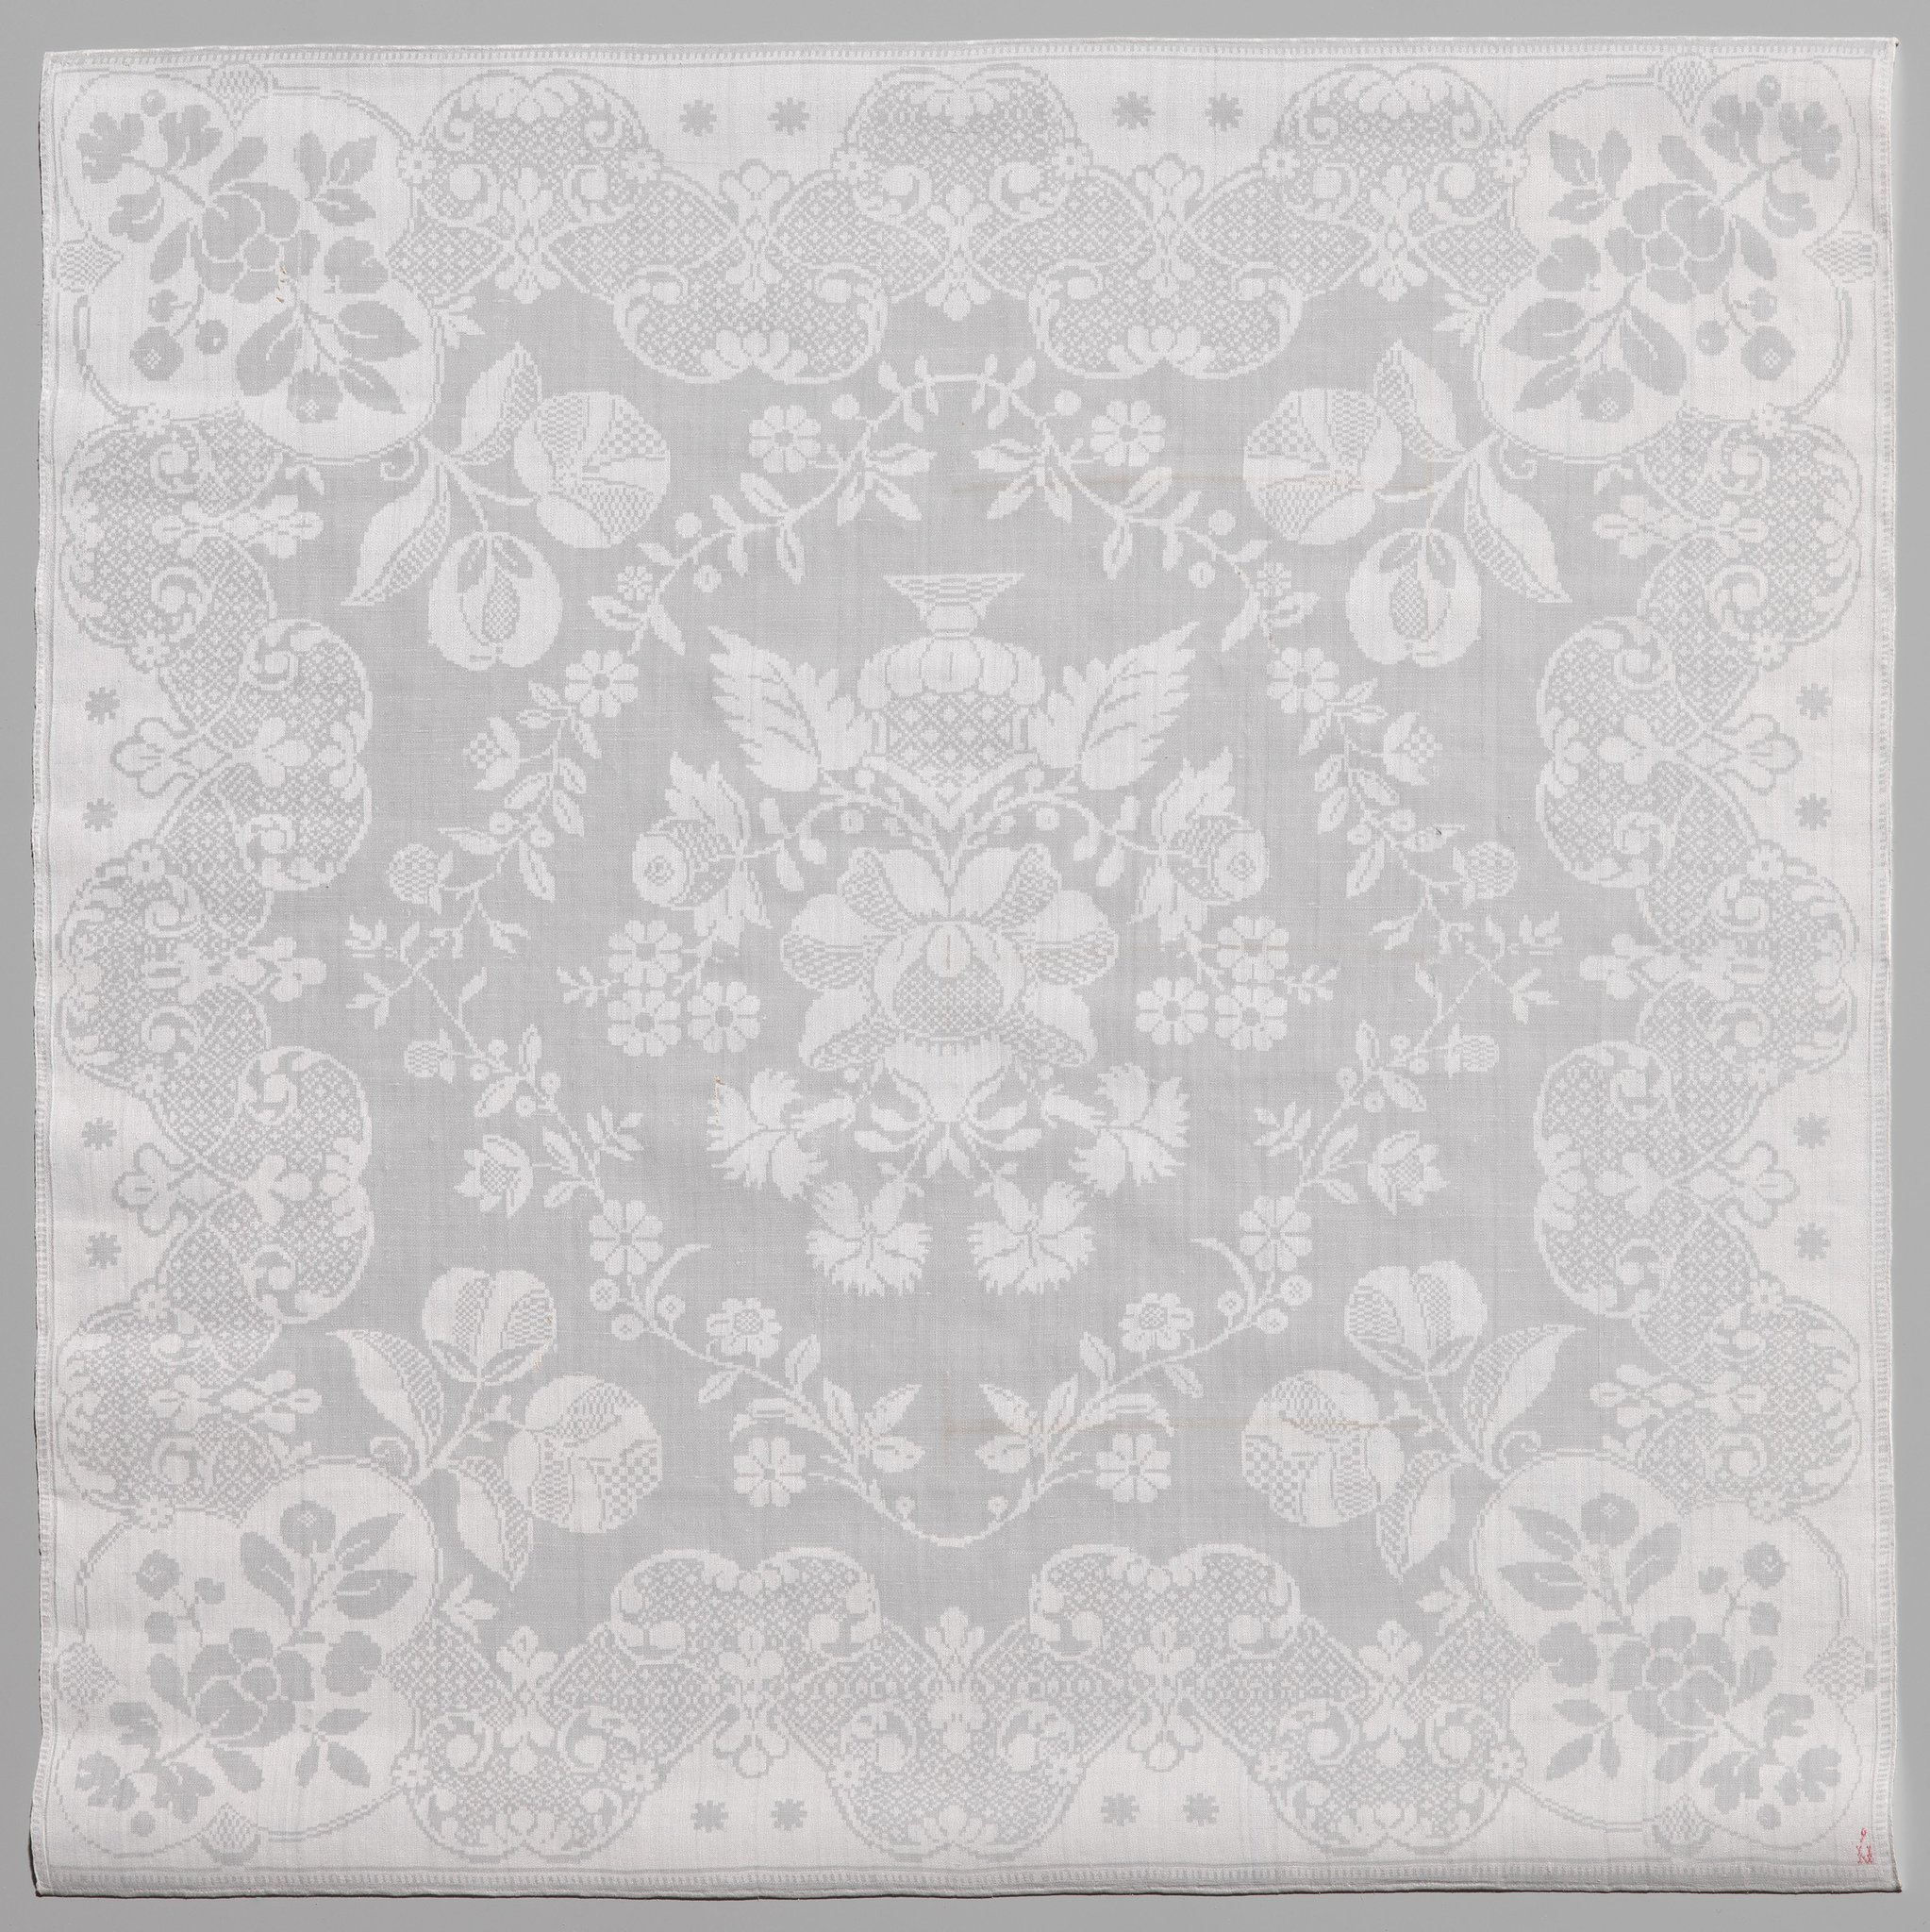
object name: napkin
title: Kantpatroon met bloemenvaas. Merk: N6 p poon.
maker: Anonymous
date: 1730-1735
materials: linen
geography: flanders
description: Servet van wit linnen met een 'kant'- patroon met bloemvaas op voet, merk N 6 p poon.